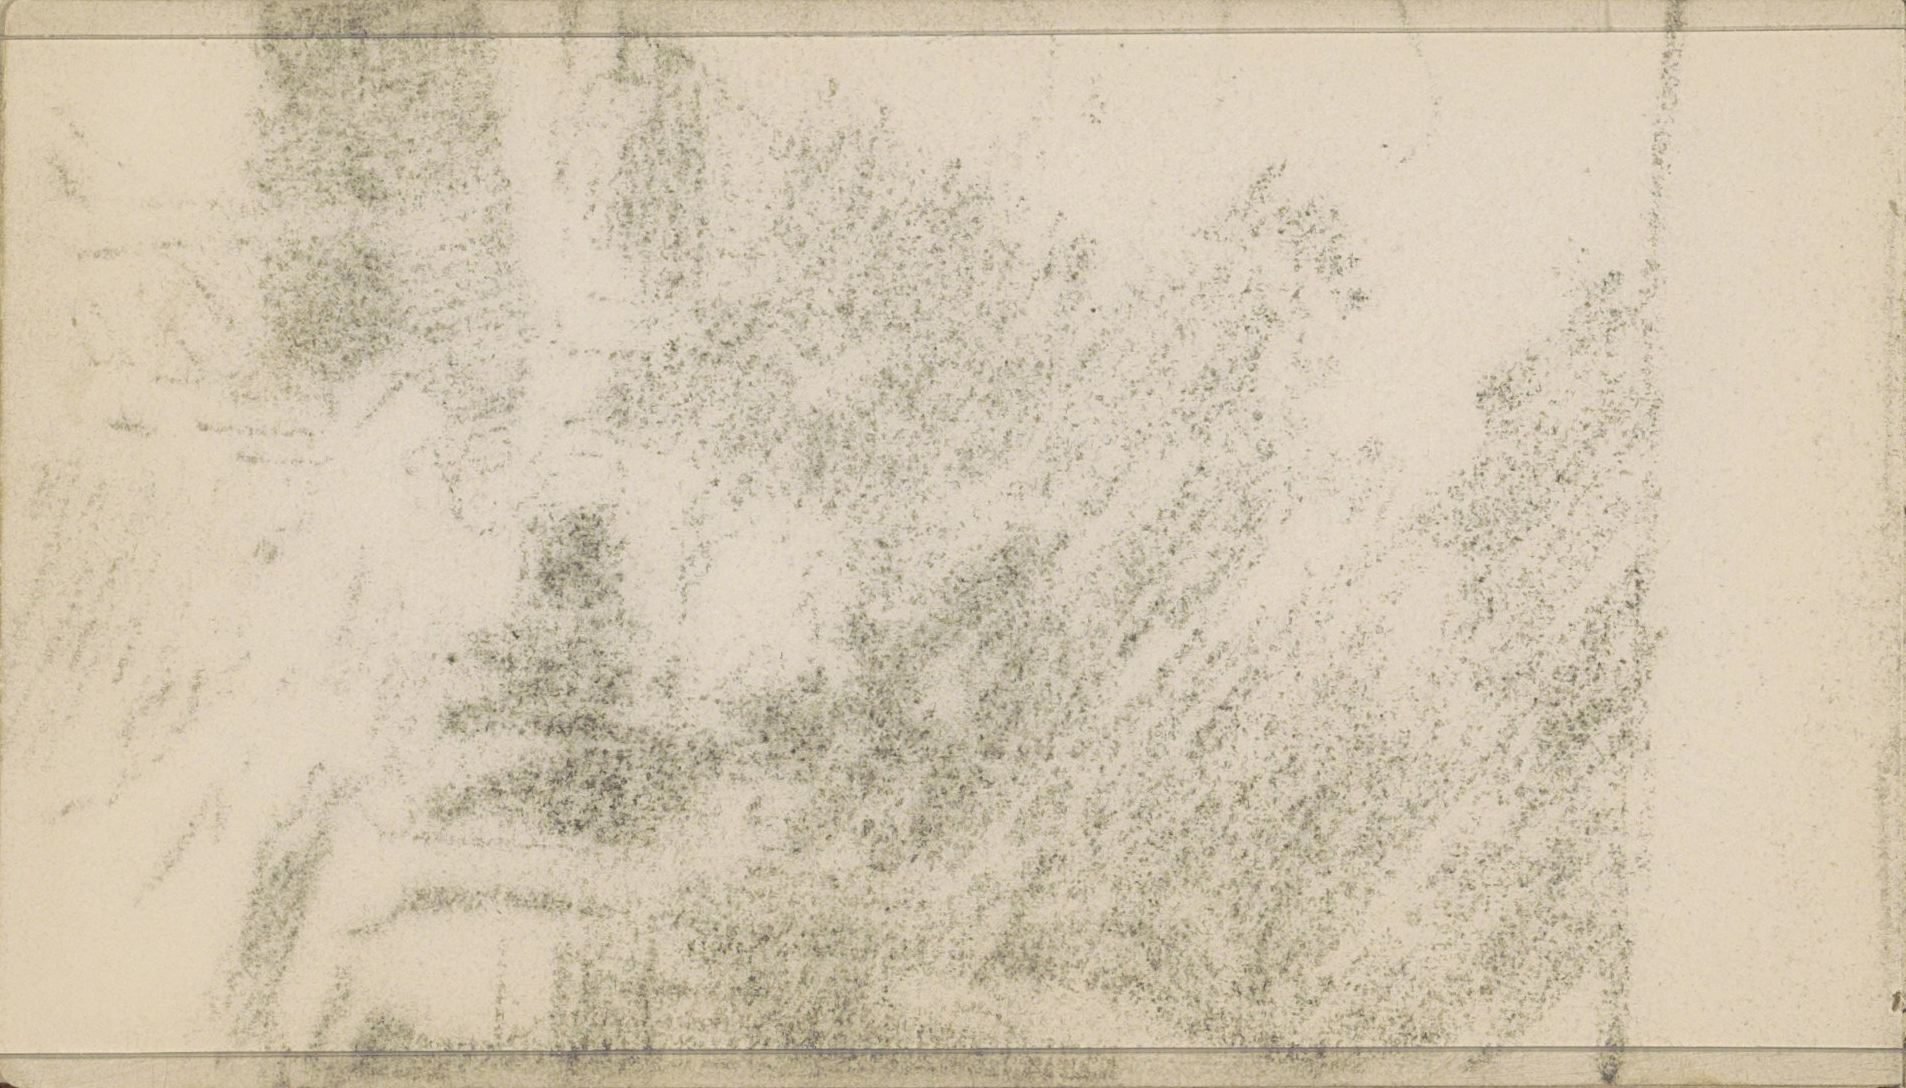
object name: sketchbook leaf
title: Abklatsch van de krijttekening op pagina 7 recto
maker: anton mauve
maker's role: draughtsman, painter, print maker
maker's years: 1838-1888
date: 1876-1879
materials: paper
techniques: printmaking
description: Blad 6 verso uit een schetsboek met 33 bladen.